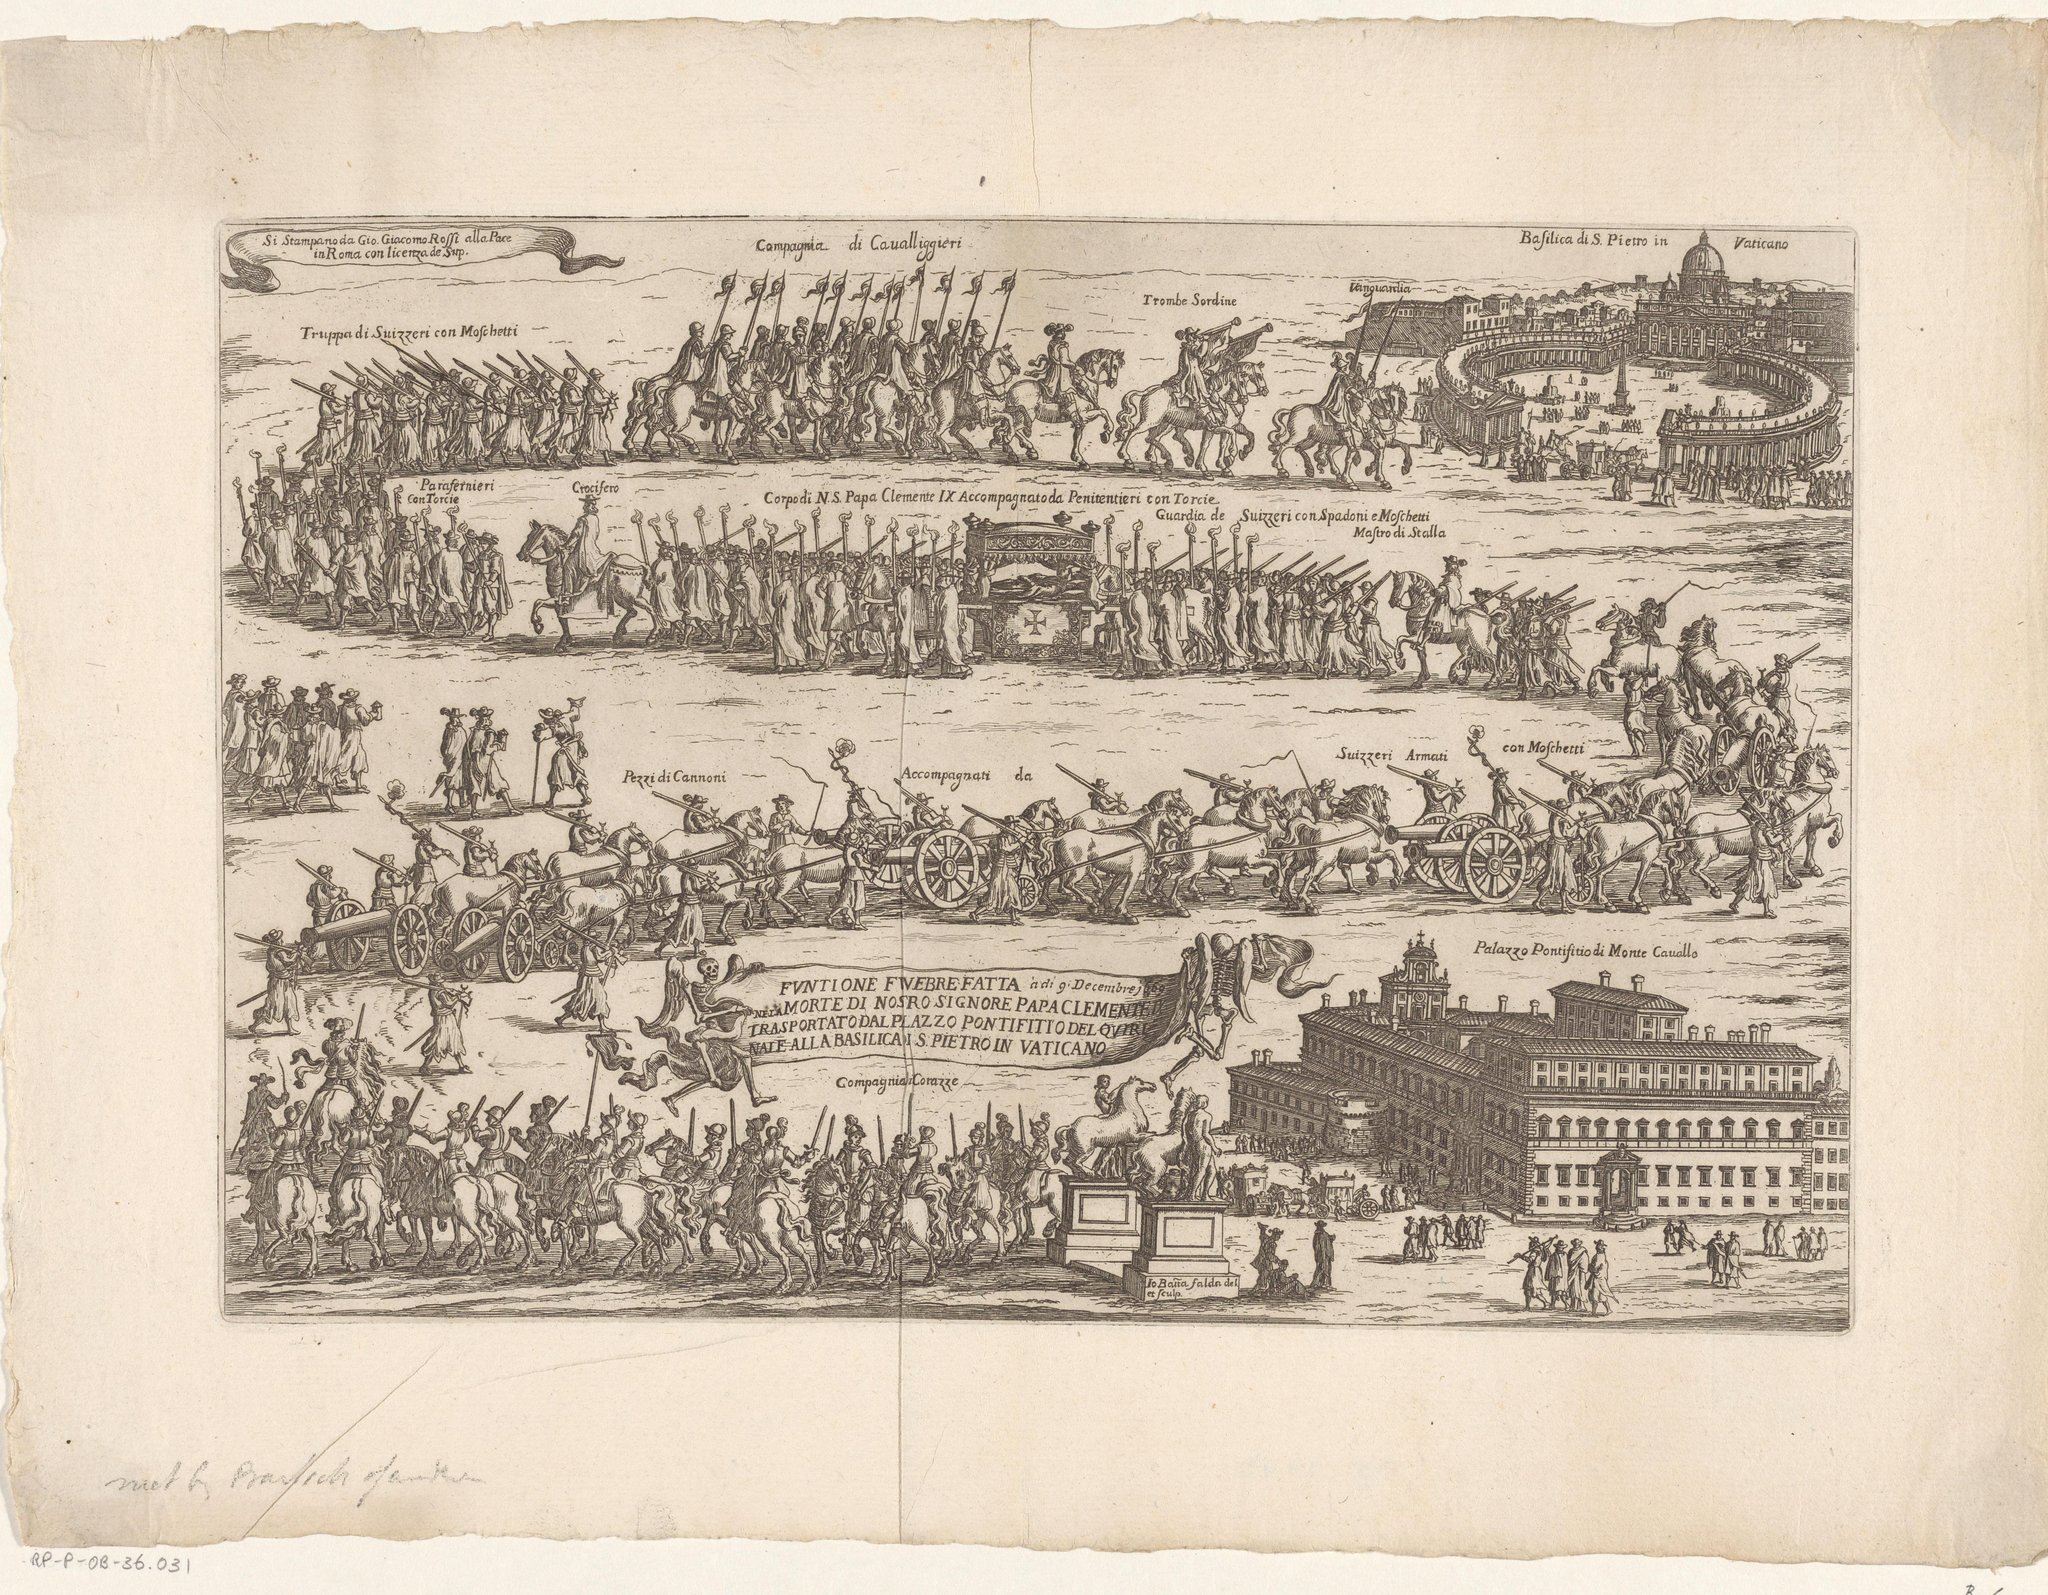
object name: print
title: Begrafenisstoet van paus Clemens IX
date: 1650-1691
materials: paper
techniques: etching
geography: italy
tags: clemens ix, cortege, funeral procession, pope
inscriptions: collector's mark: Lugt 2228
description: De begrafenisstoet van paus Clemens IX van het Palazzo del Quirinale naar de Sint-Pietersbasiliek te Rome. Midden onder twee gevleugelde skeletten die een doek met opschrift dragen.